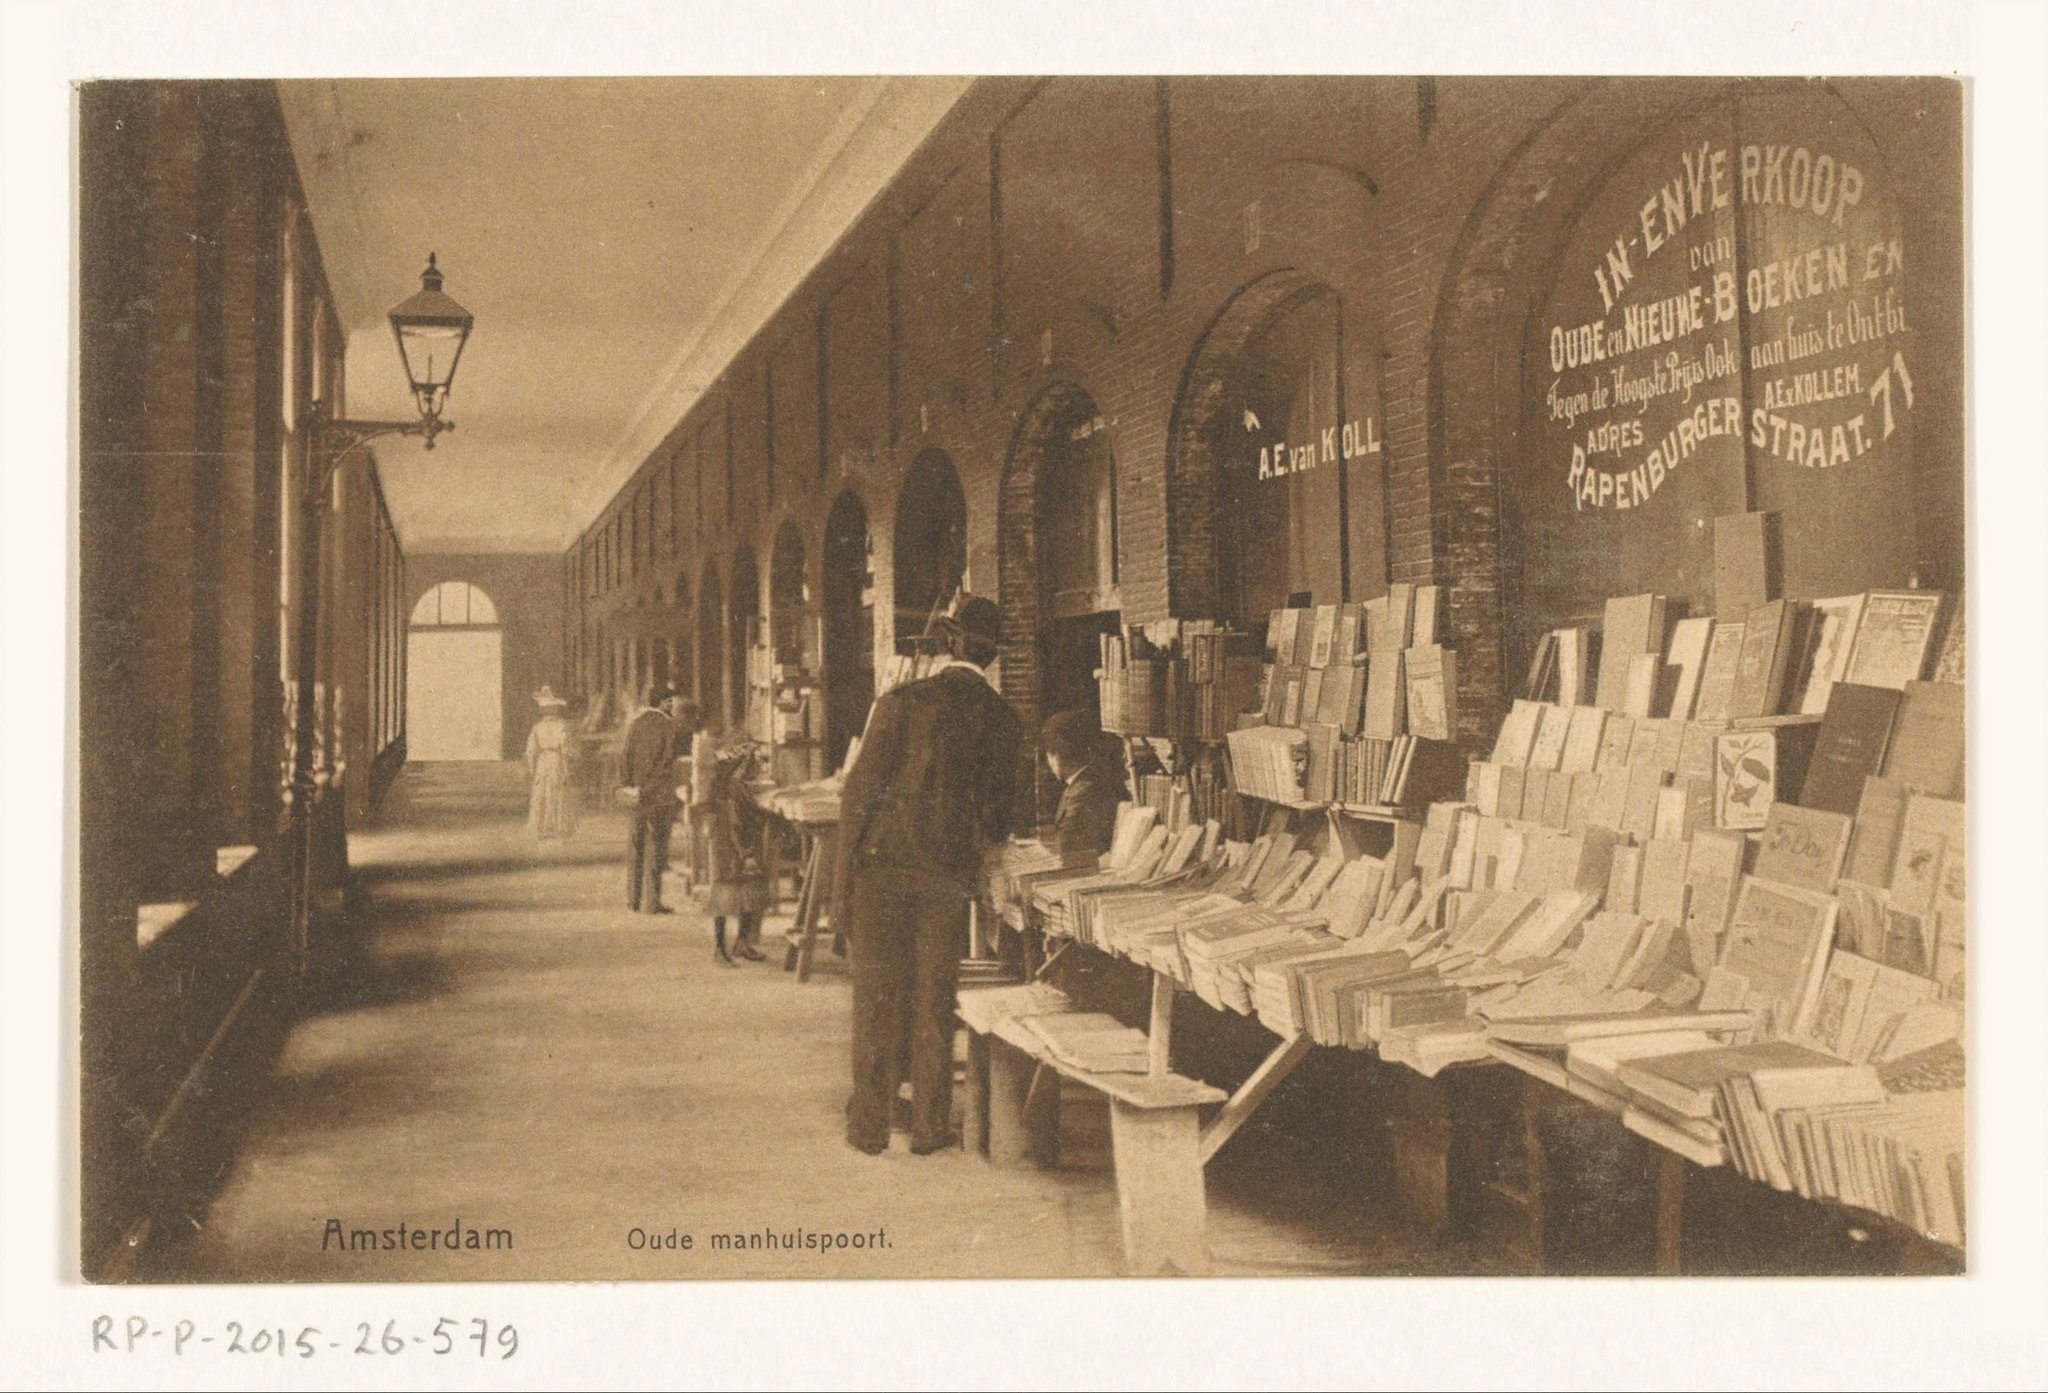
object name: print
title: Boekenkraam van Aäron Eliazer van Kollem in de Oudemanhuispoort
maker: Anonymous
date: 1905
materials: paper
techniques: photograph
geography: hamburg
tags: book-shop, bookseller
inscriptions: collector's mark: Lugt 4779, collector's mark: Lugt 2228